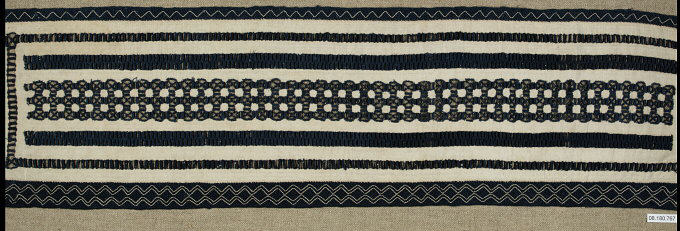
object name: fragment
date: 1701-1800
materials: linen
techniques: embroidery